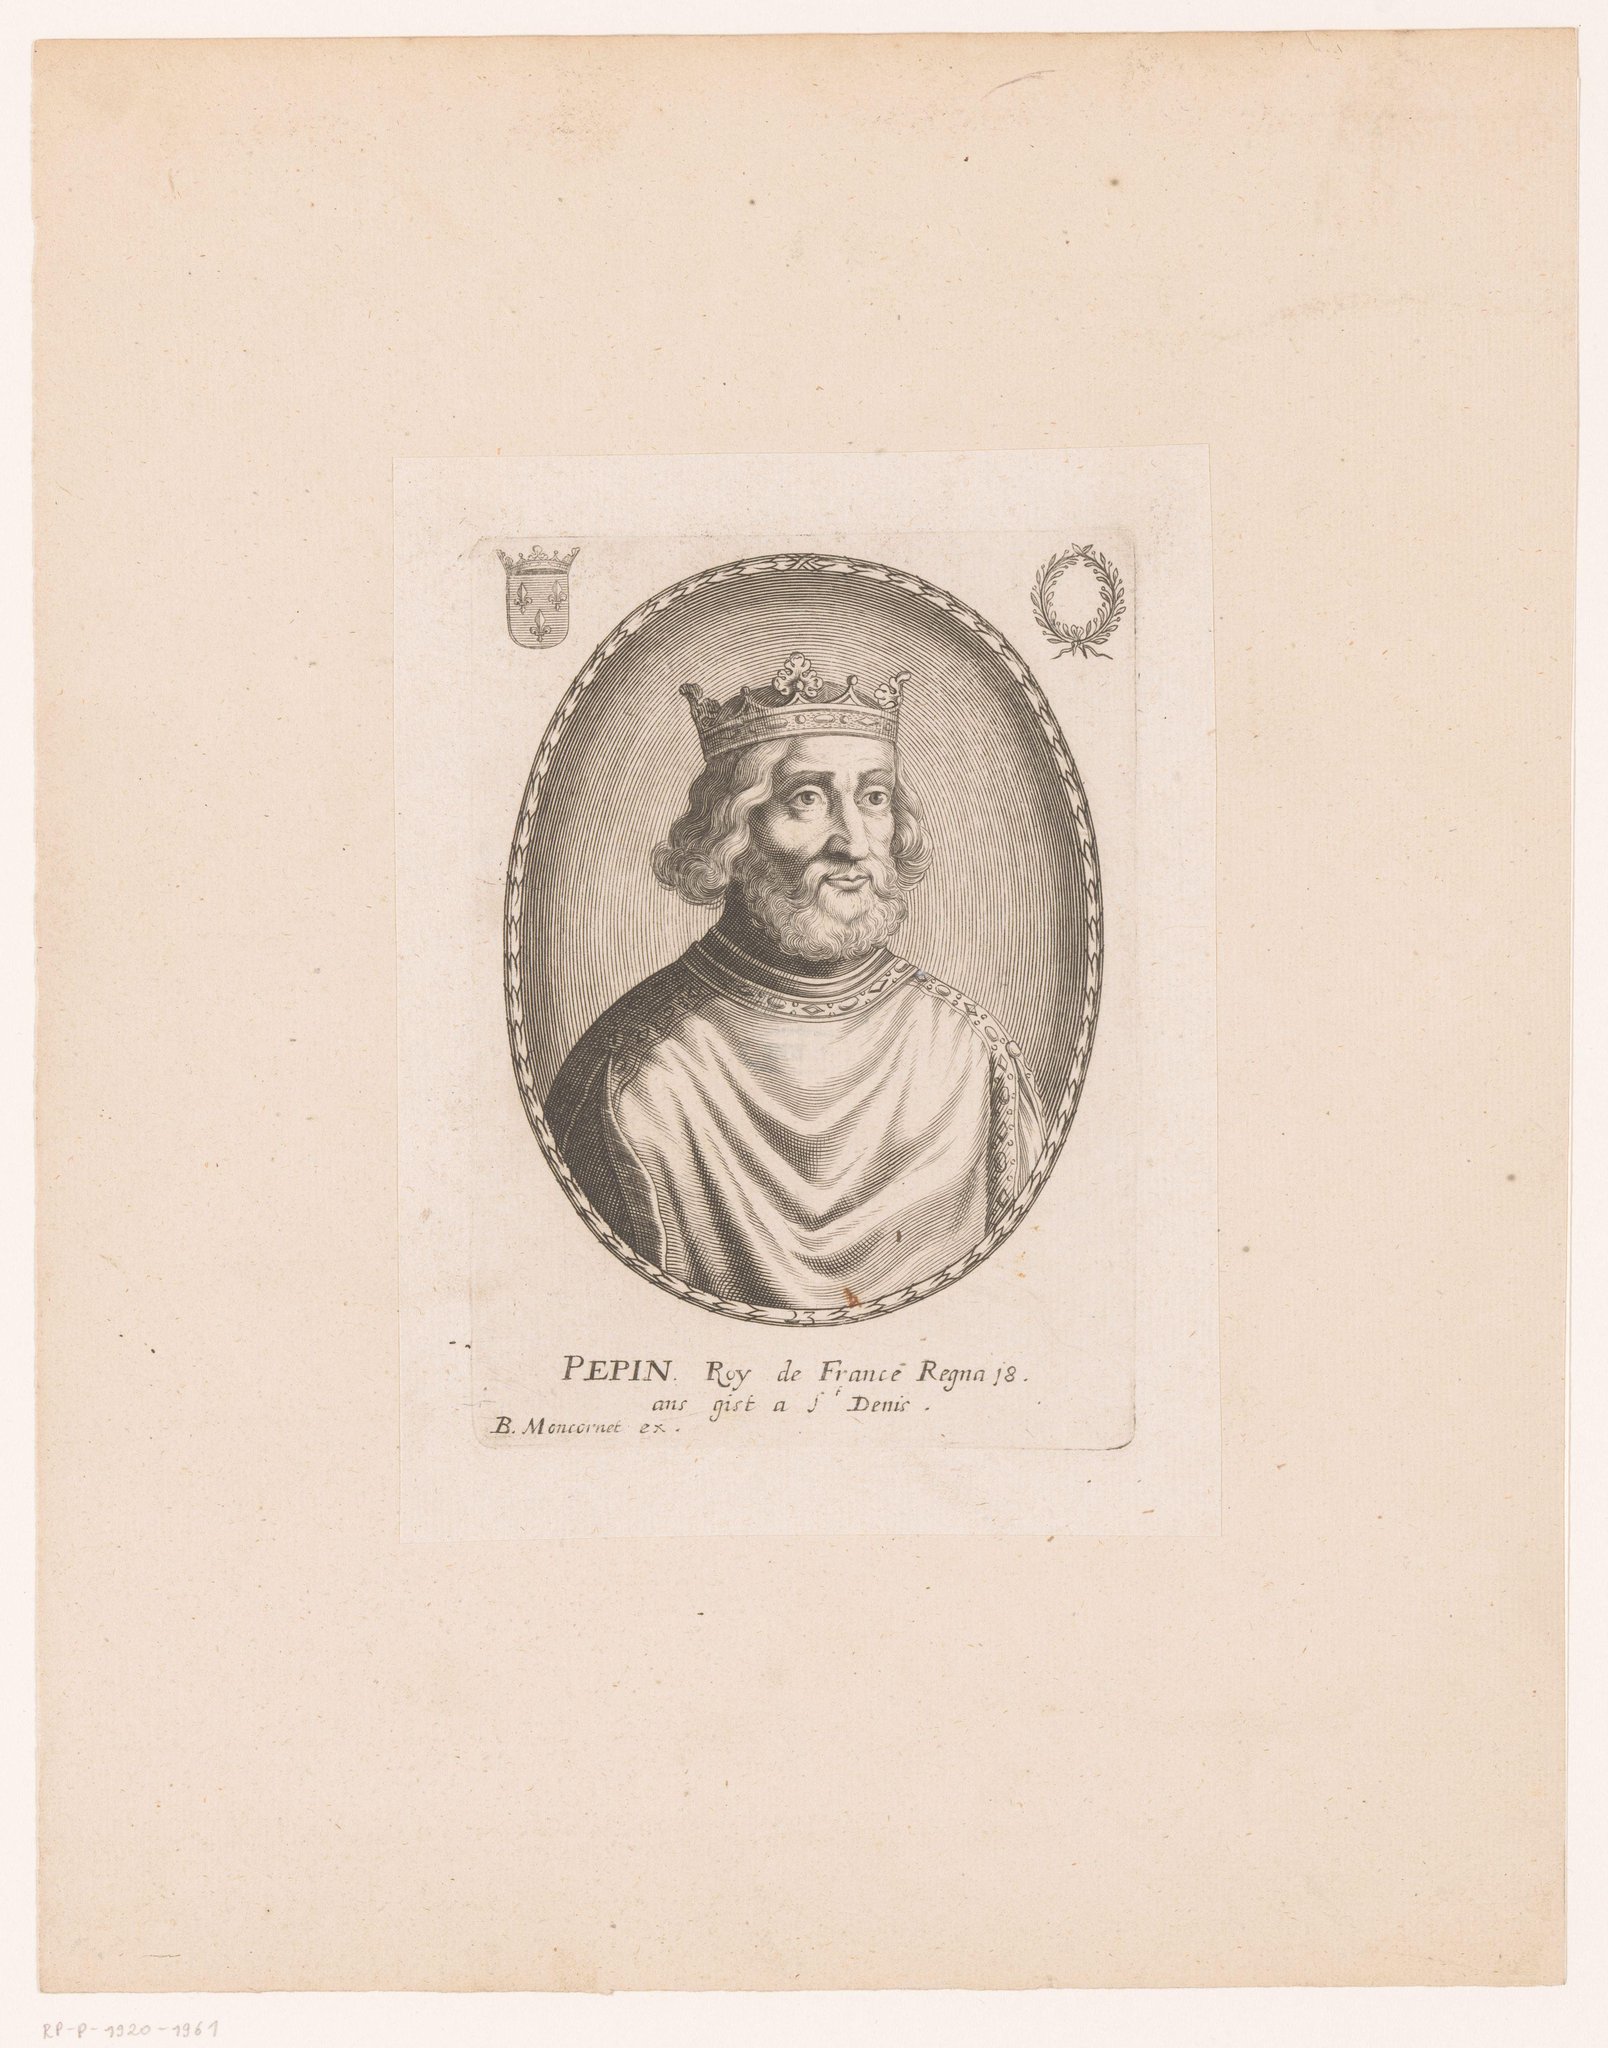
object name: print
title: Portret van Pepijn de Korte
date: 1610-1668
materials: paper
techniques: engraving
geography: paris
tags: liège, historical persons, king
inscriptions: collector's mark: Lugt 2228